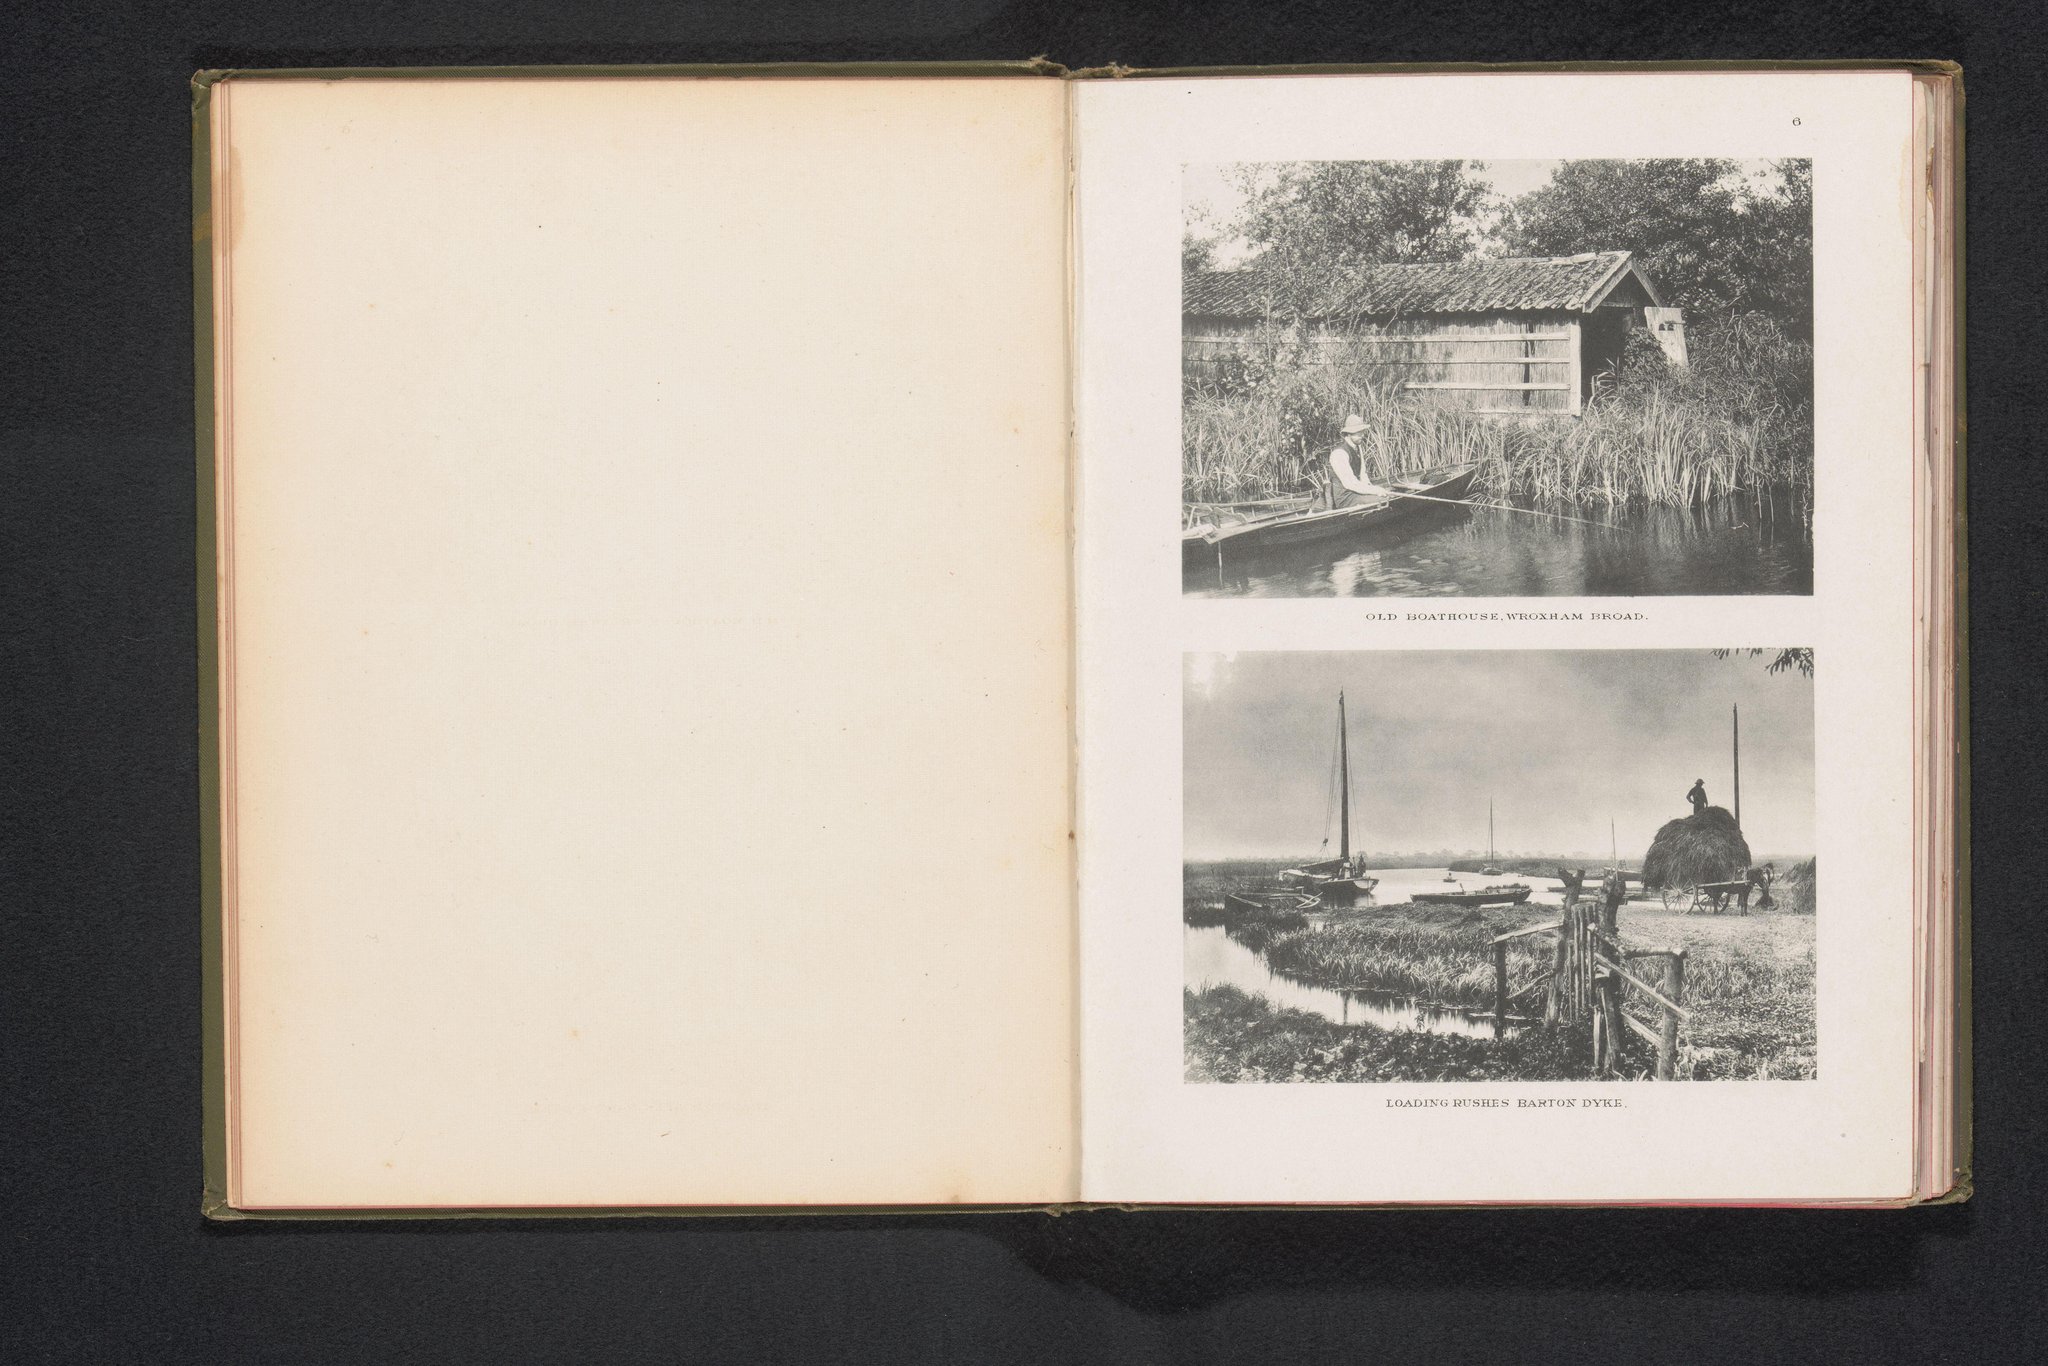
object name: page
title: Rivierlandschap met boten en een beladen kar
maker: john payne jennings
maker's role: fotograaf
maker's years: 1843-1926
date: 1886-1891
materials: paper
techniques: photograph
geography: norfolk broads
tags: sailing-ship, sailing-boat, landscapes with waters, waterscapes, seascapes (in the temperate zone), (farm) wagon, freight wagon, cart